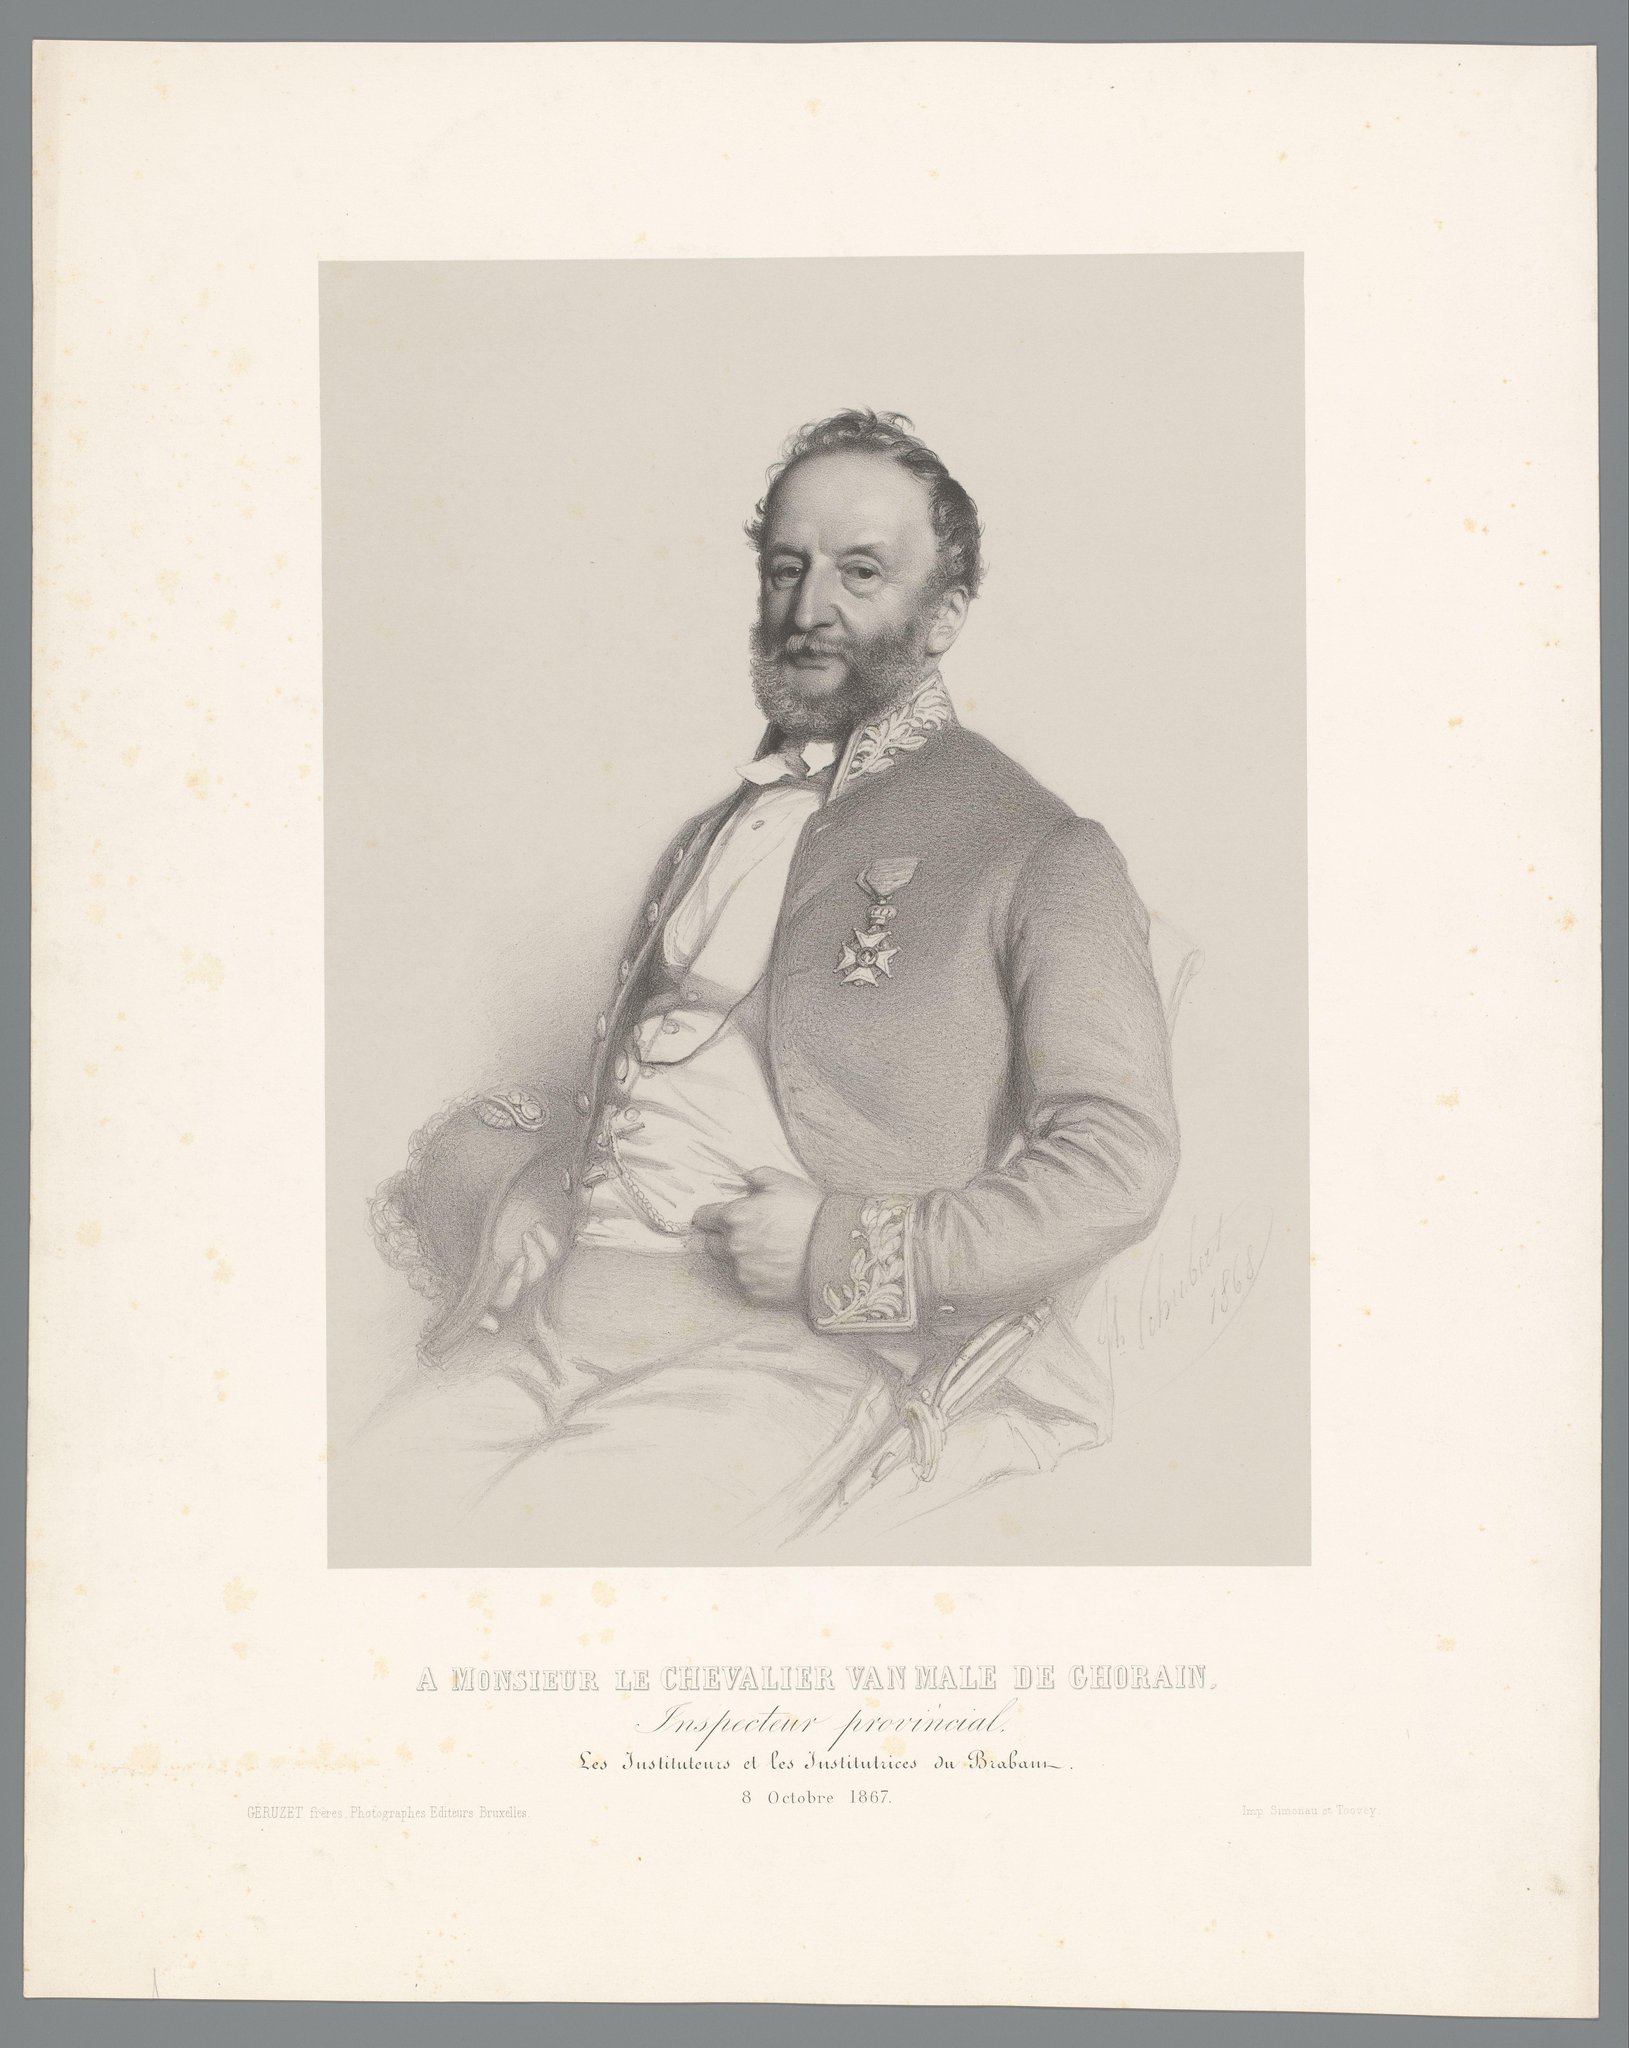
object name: print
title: Portret van Josse van Male de Ghorain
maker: joseph schubert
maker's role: print maker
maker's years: 1816-1885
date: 1868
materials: paper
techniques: lithograph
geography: brussels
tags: historical persons, lawyer, attorney at law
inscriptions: collector's mark: Lugt 2228